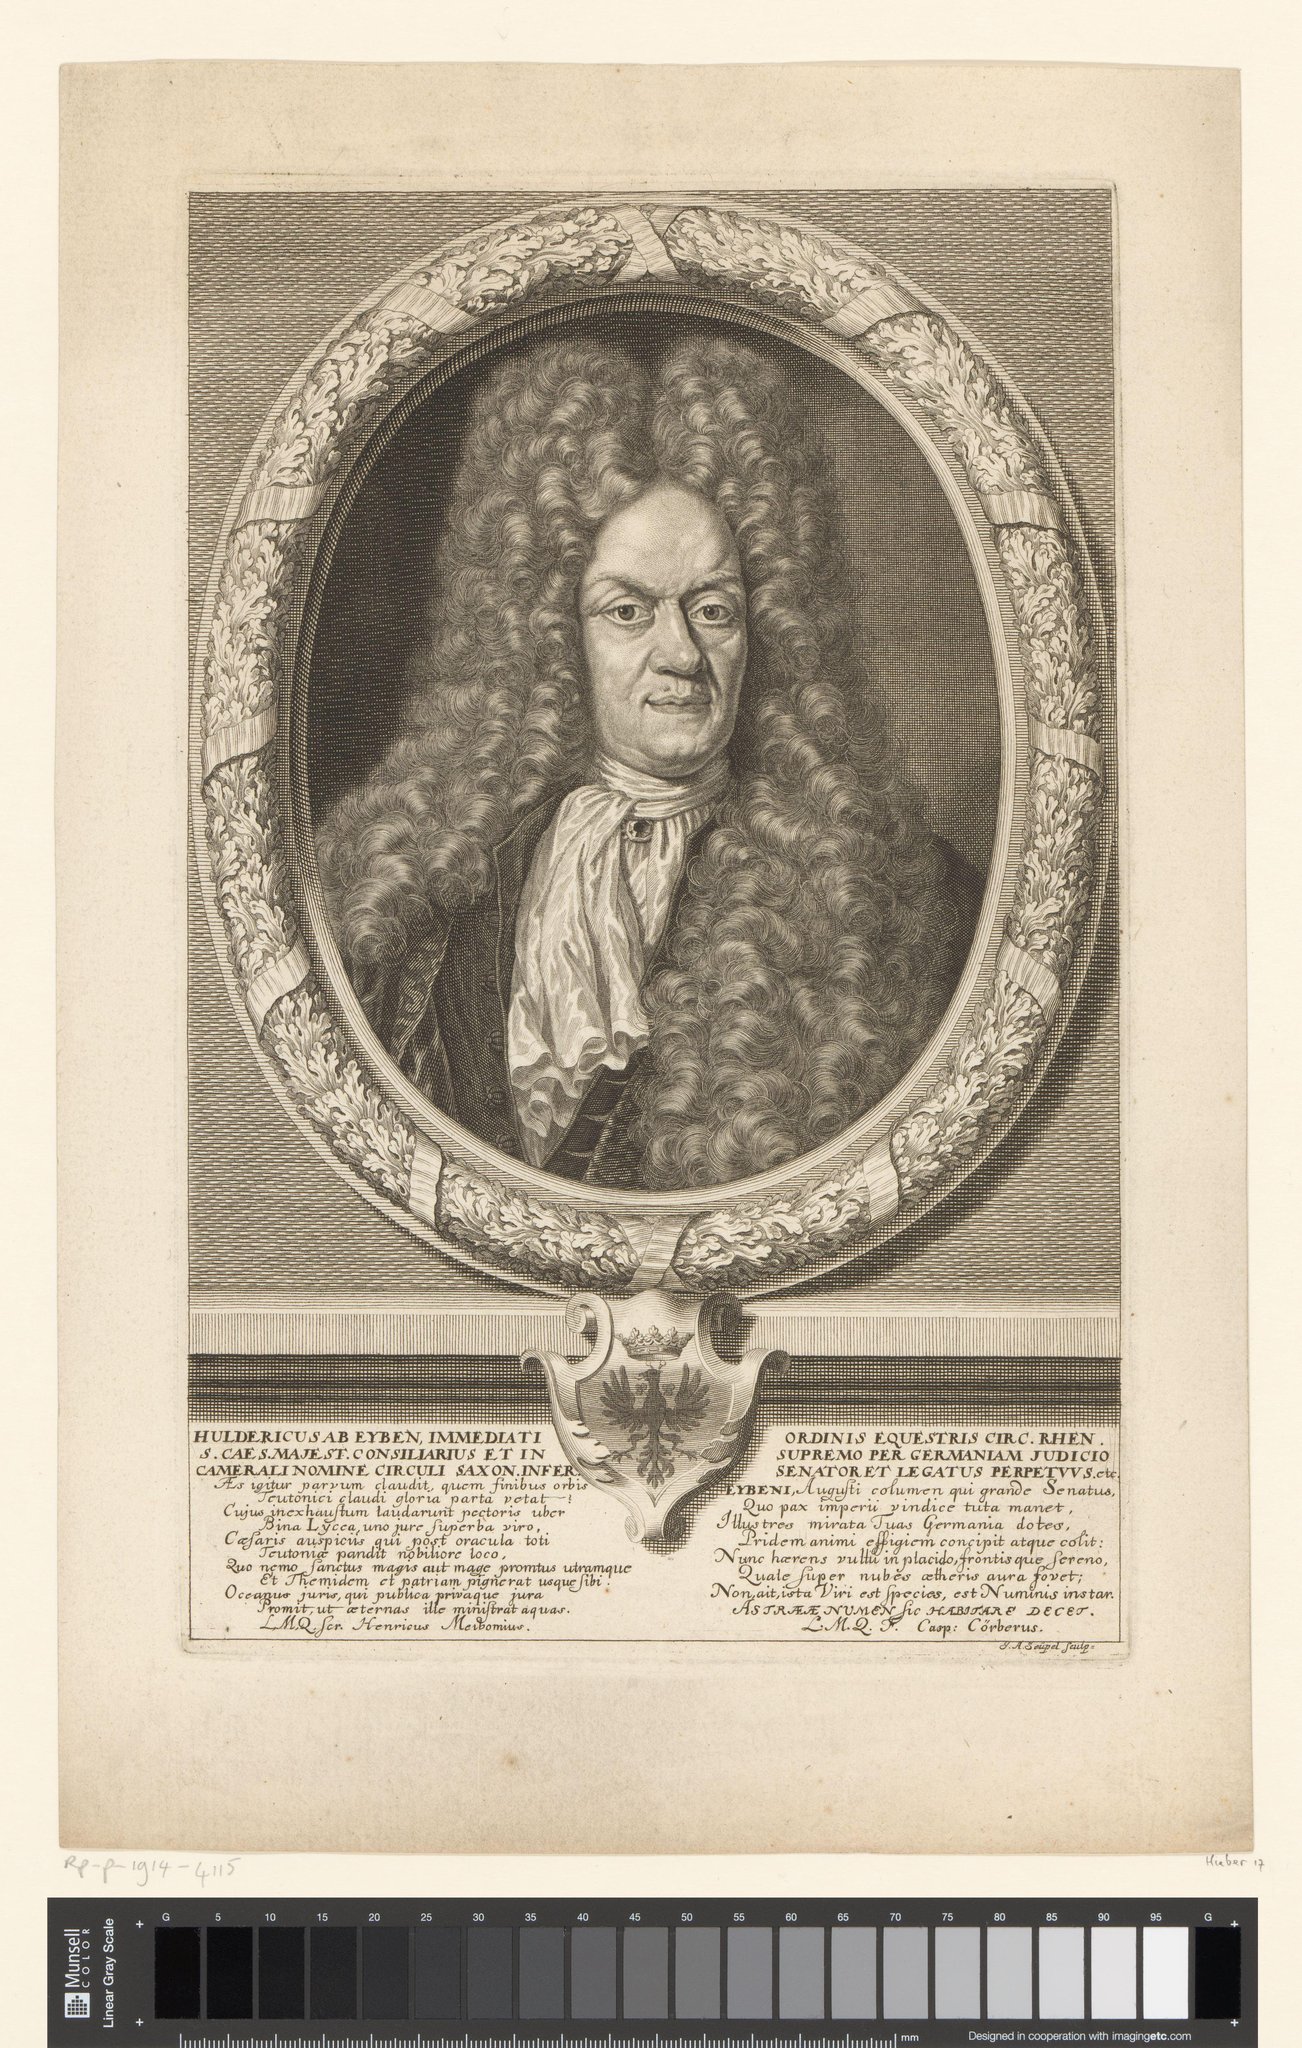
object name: print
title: Portret van Huldrich von Eyben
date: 1682-1717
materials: paper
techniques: engraving, etching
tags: historical persons, armorial bearing, heraldry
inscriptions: collector's mark: Lugt 2228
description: Prent ook gebruikt in: Eyben, Huldrich von. Scripta (...) de jure civili privato, publico & feudali (...). Strassburg: Johann Reinhold Dulssecker, 1708.